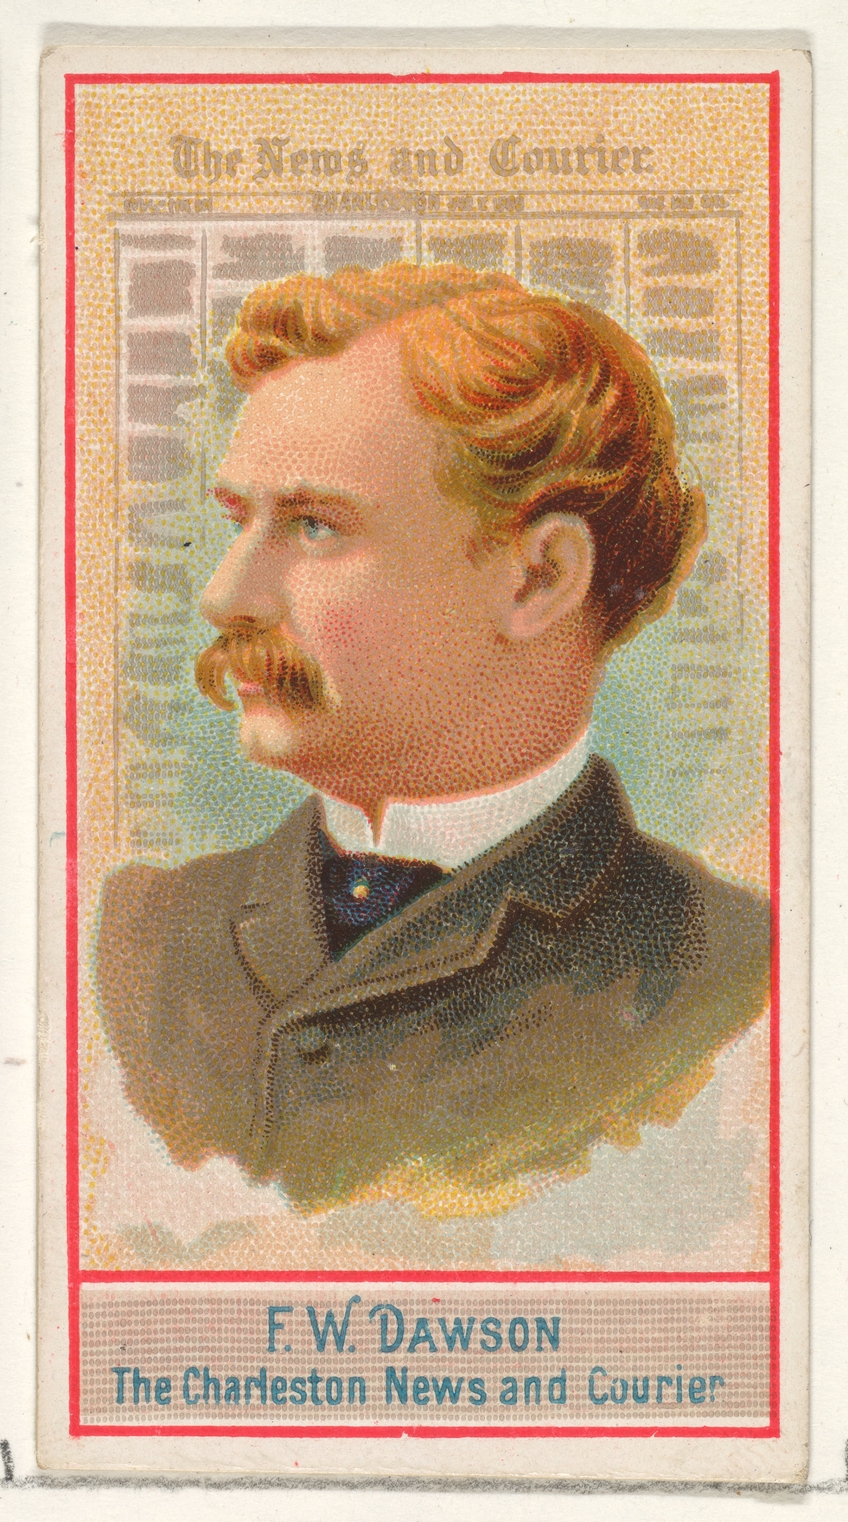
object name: print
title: F.W. Dawson, The Charleston News and Courier, from the American Editors series (N1) for Allen & Ginter Cigarettes Brands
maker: allen & ginter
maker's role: publisher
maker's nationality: american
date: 1887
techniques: color lithograph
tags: men